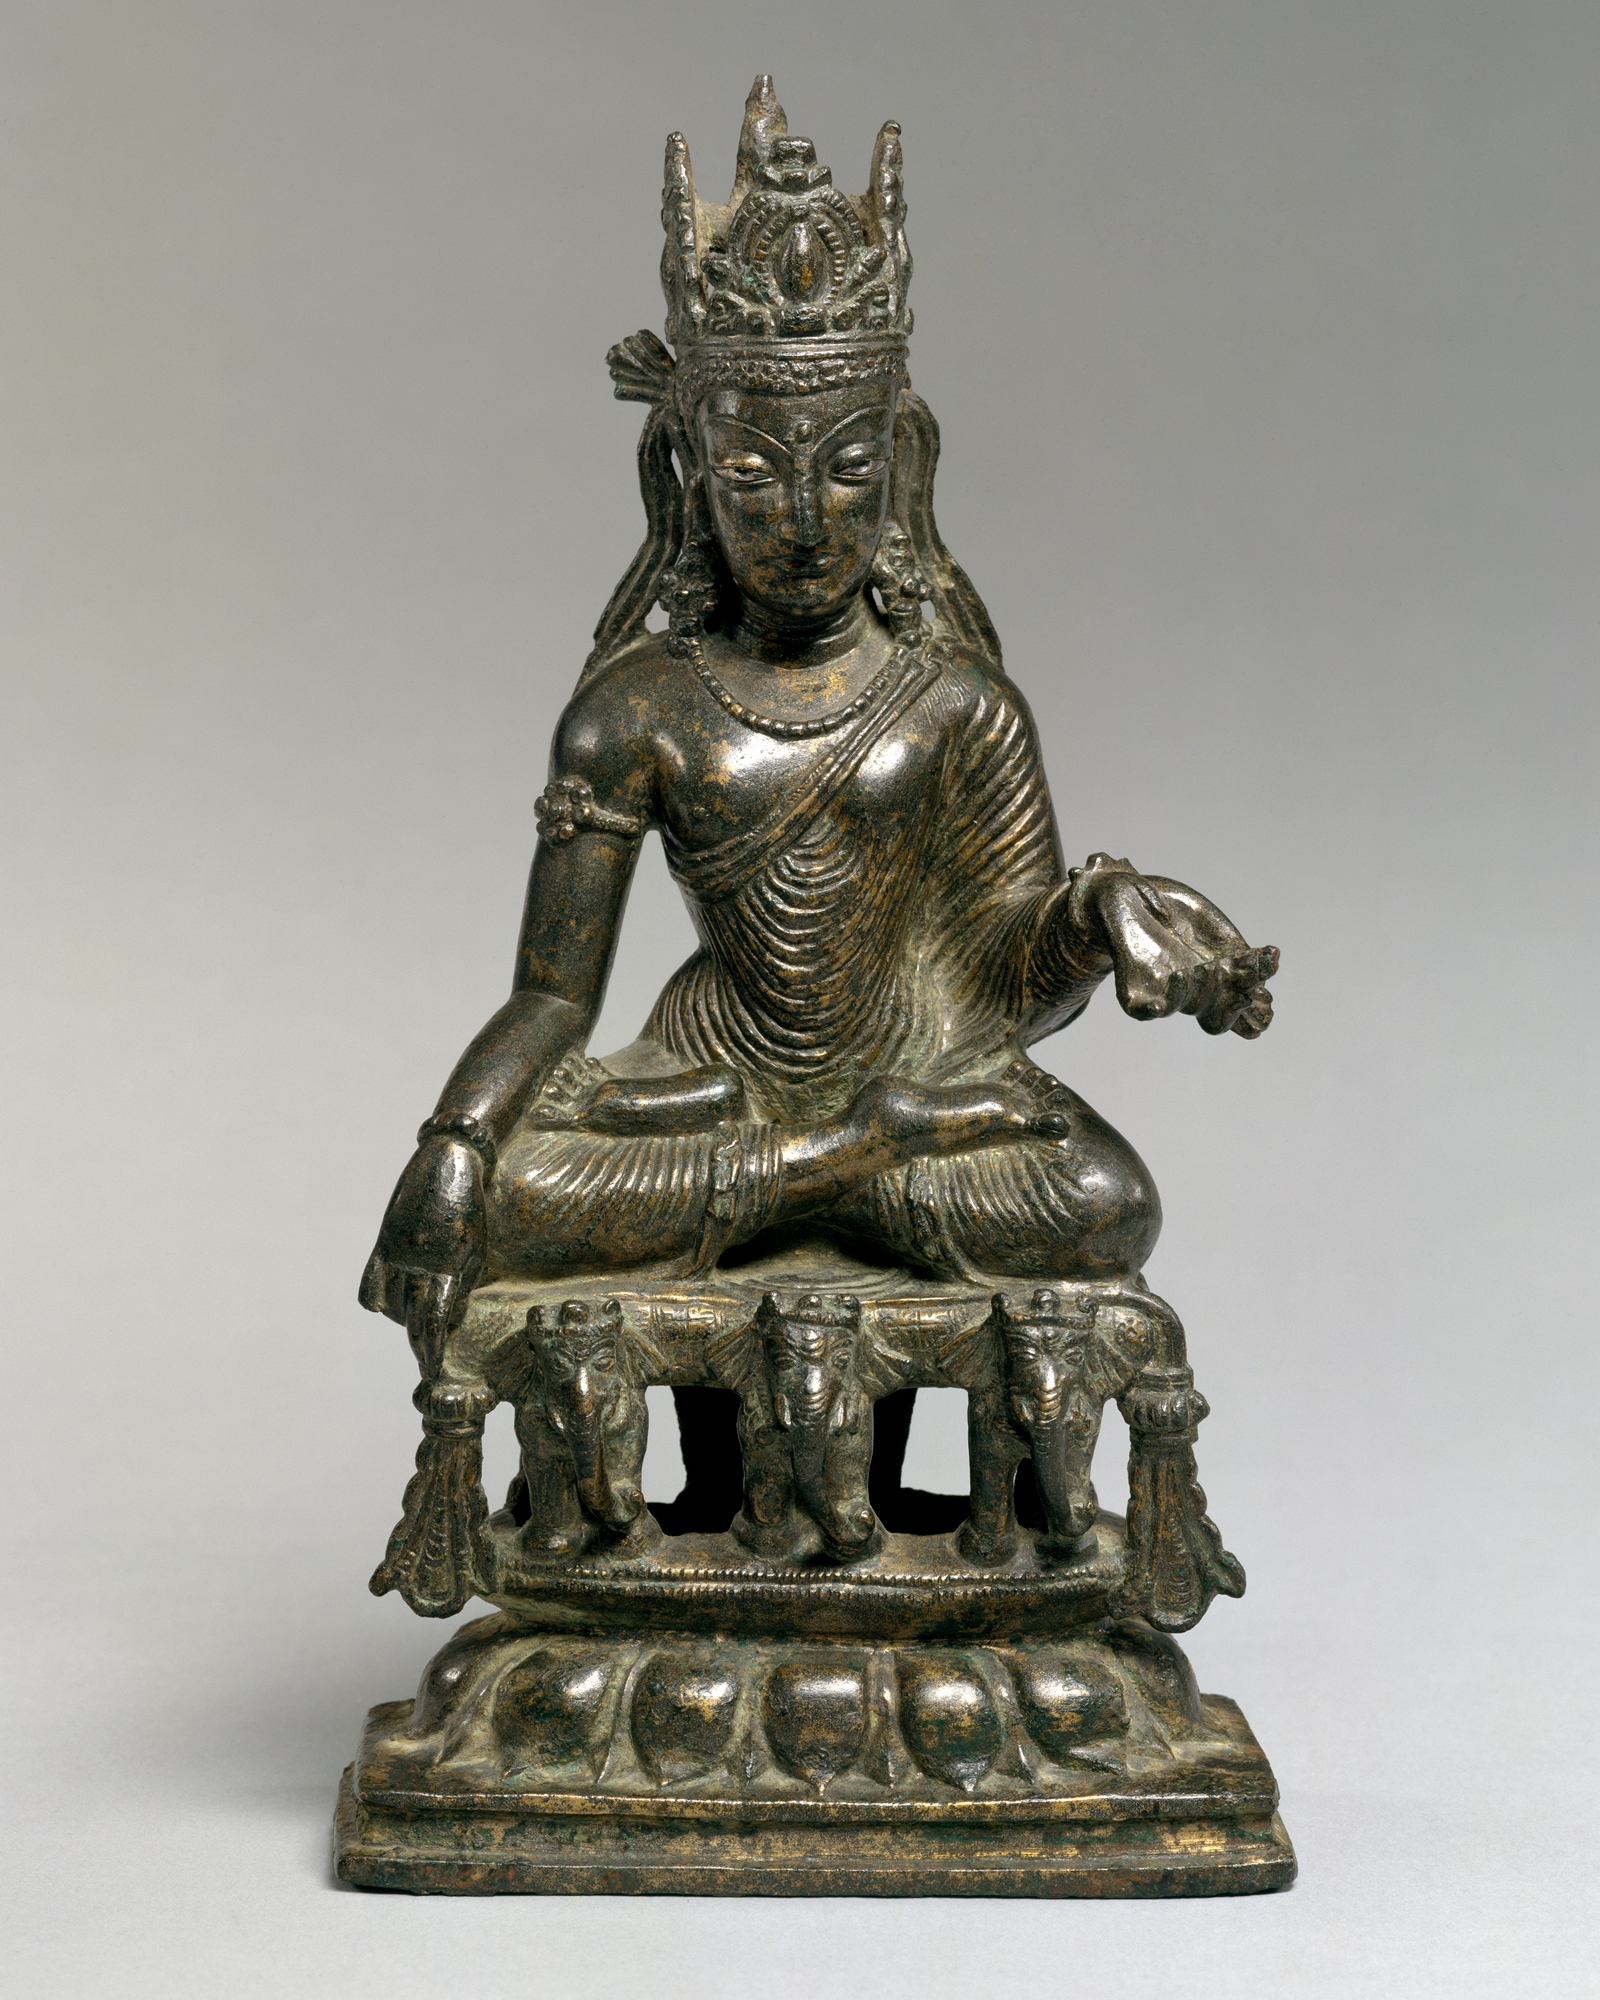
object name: figure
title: Akshobhya, the Transcendent Buddha of the East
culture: pakistani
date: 801-900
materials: bronze, copper, silver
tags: swat valley,buddhism,akshobhya